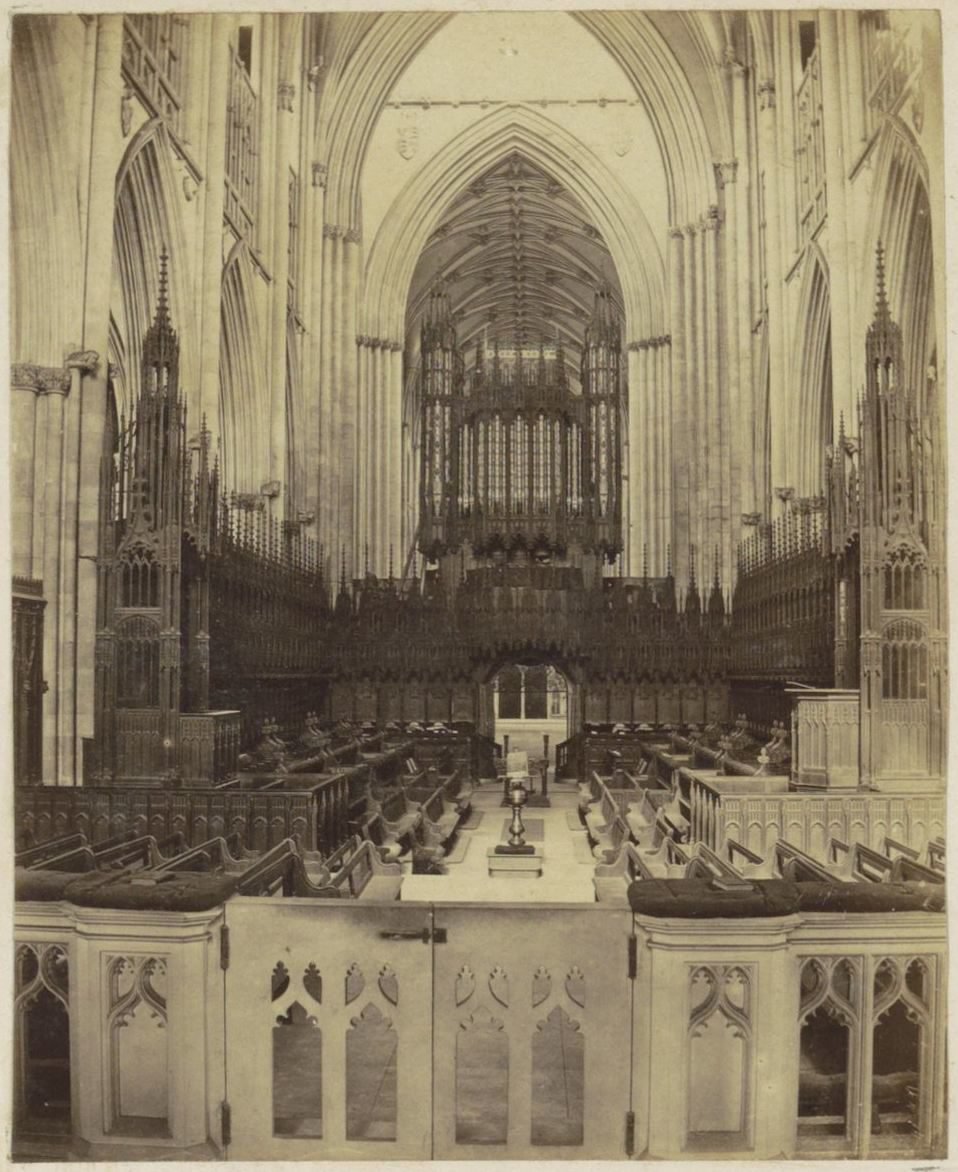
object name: photograph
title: Schip van een kathedraal in Engeland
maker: Anonymous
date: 1850-1870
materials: paper, photographic support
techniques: albumen print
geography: england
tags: parts of church interior: nave, england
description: Onderdeel van Album met foto's van bezienswaardigheden en landschappen in Engeland en van kunst.